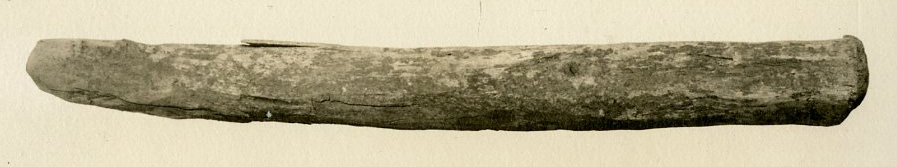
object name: stake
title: Stake?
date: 2649-2100 BCE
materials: wood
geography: egypt